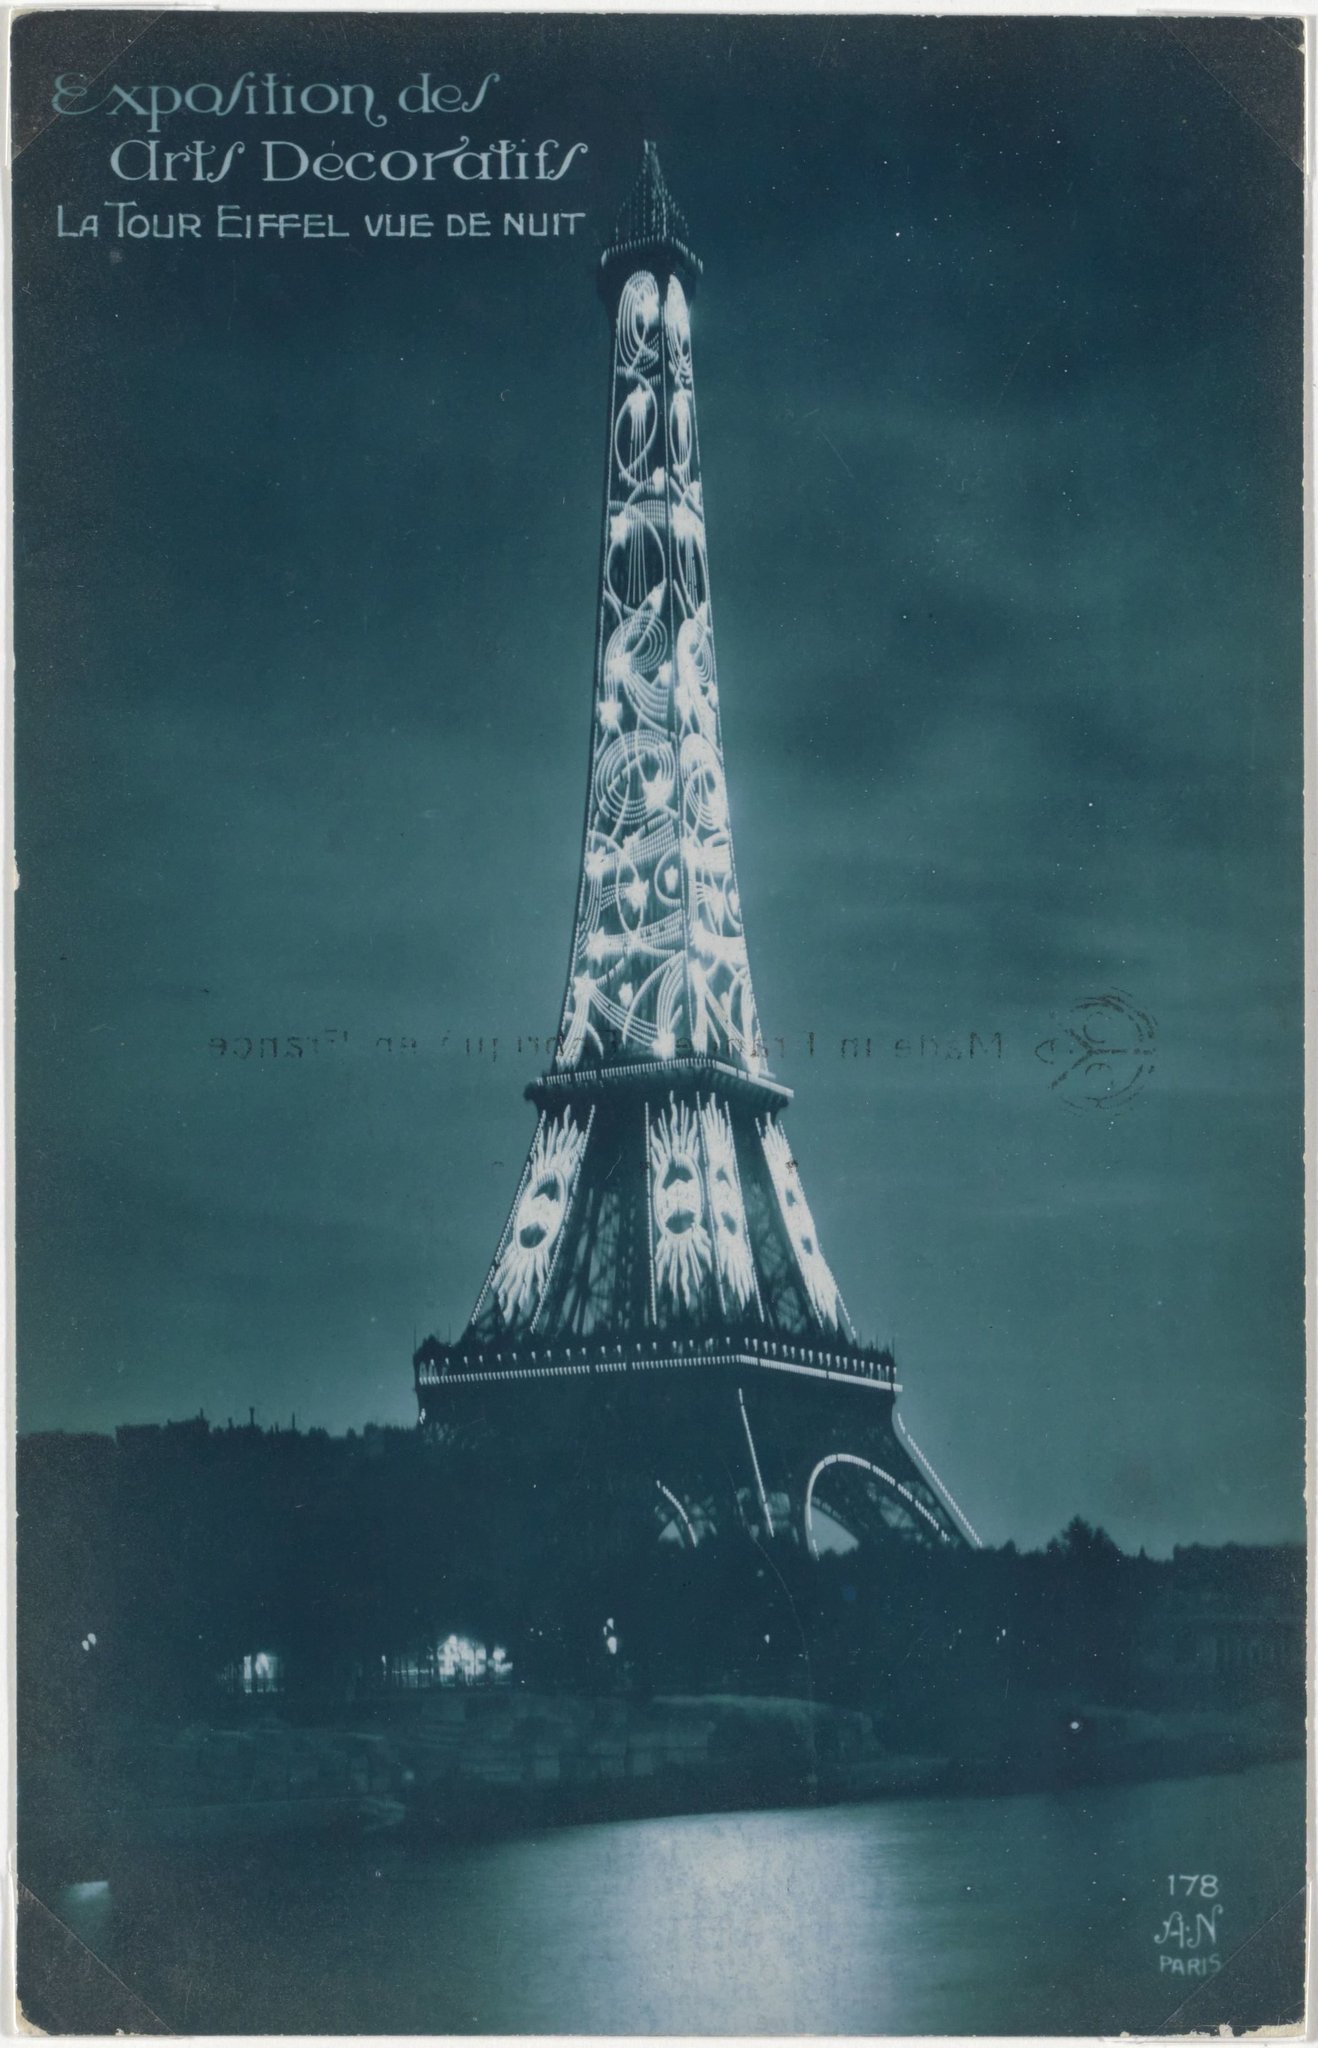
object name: ansichtkaart, prentbriefkaart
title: Exposition des Arts Décoratifs La Tour Eiffel vue de nuit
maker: Anonymous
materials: paper, photographic support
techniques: gelatin silver print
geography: paris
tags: eiffel tower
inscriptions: inscription: ‘178 A.N. Paris’